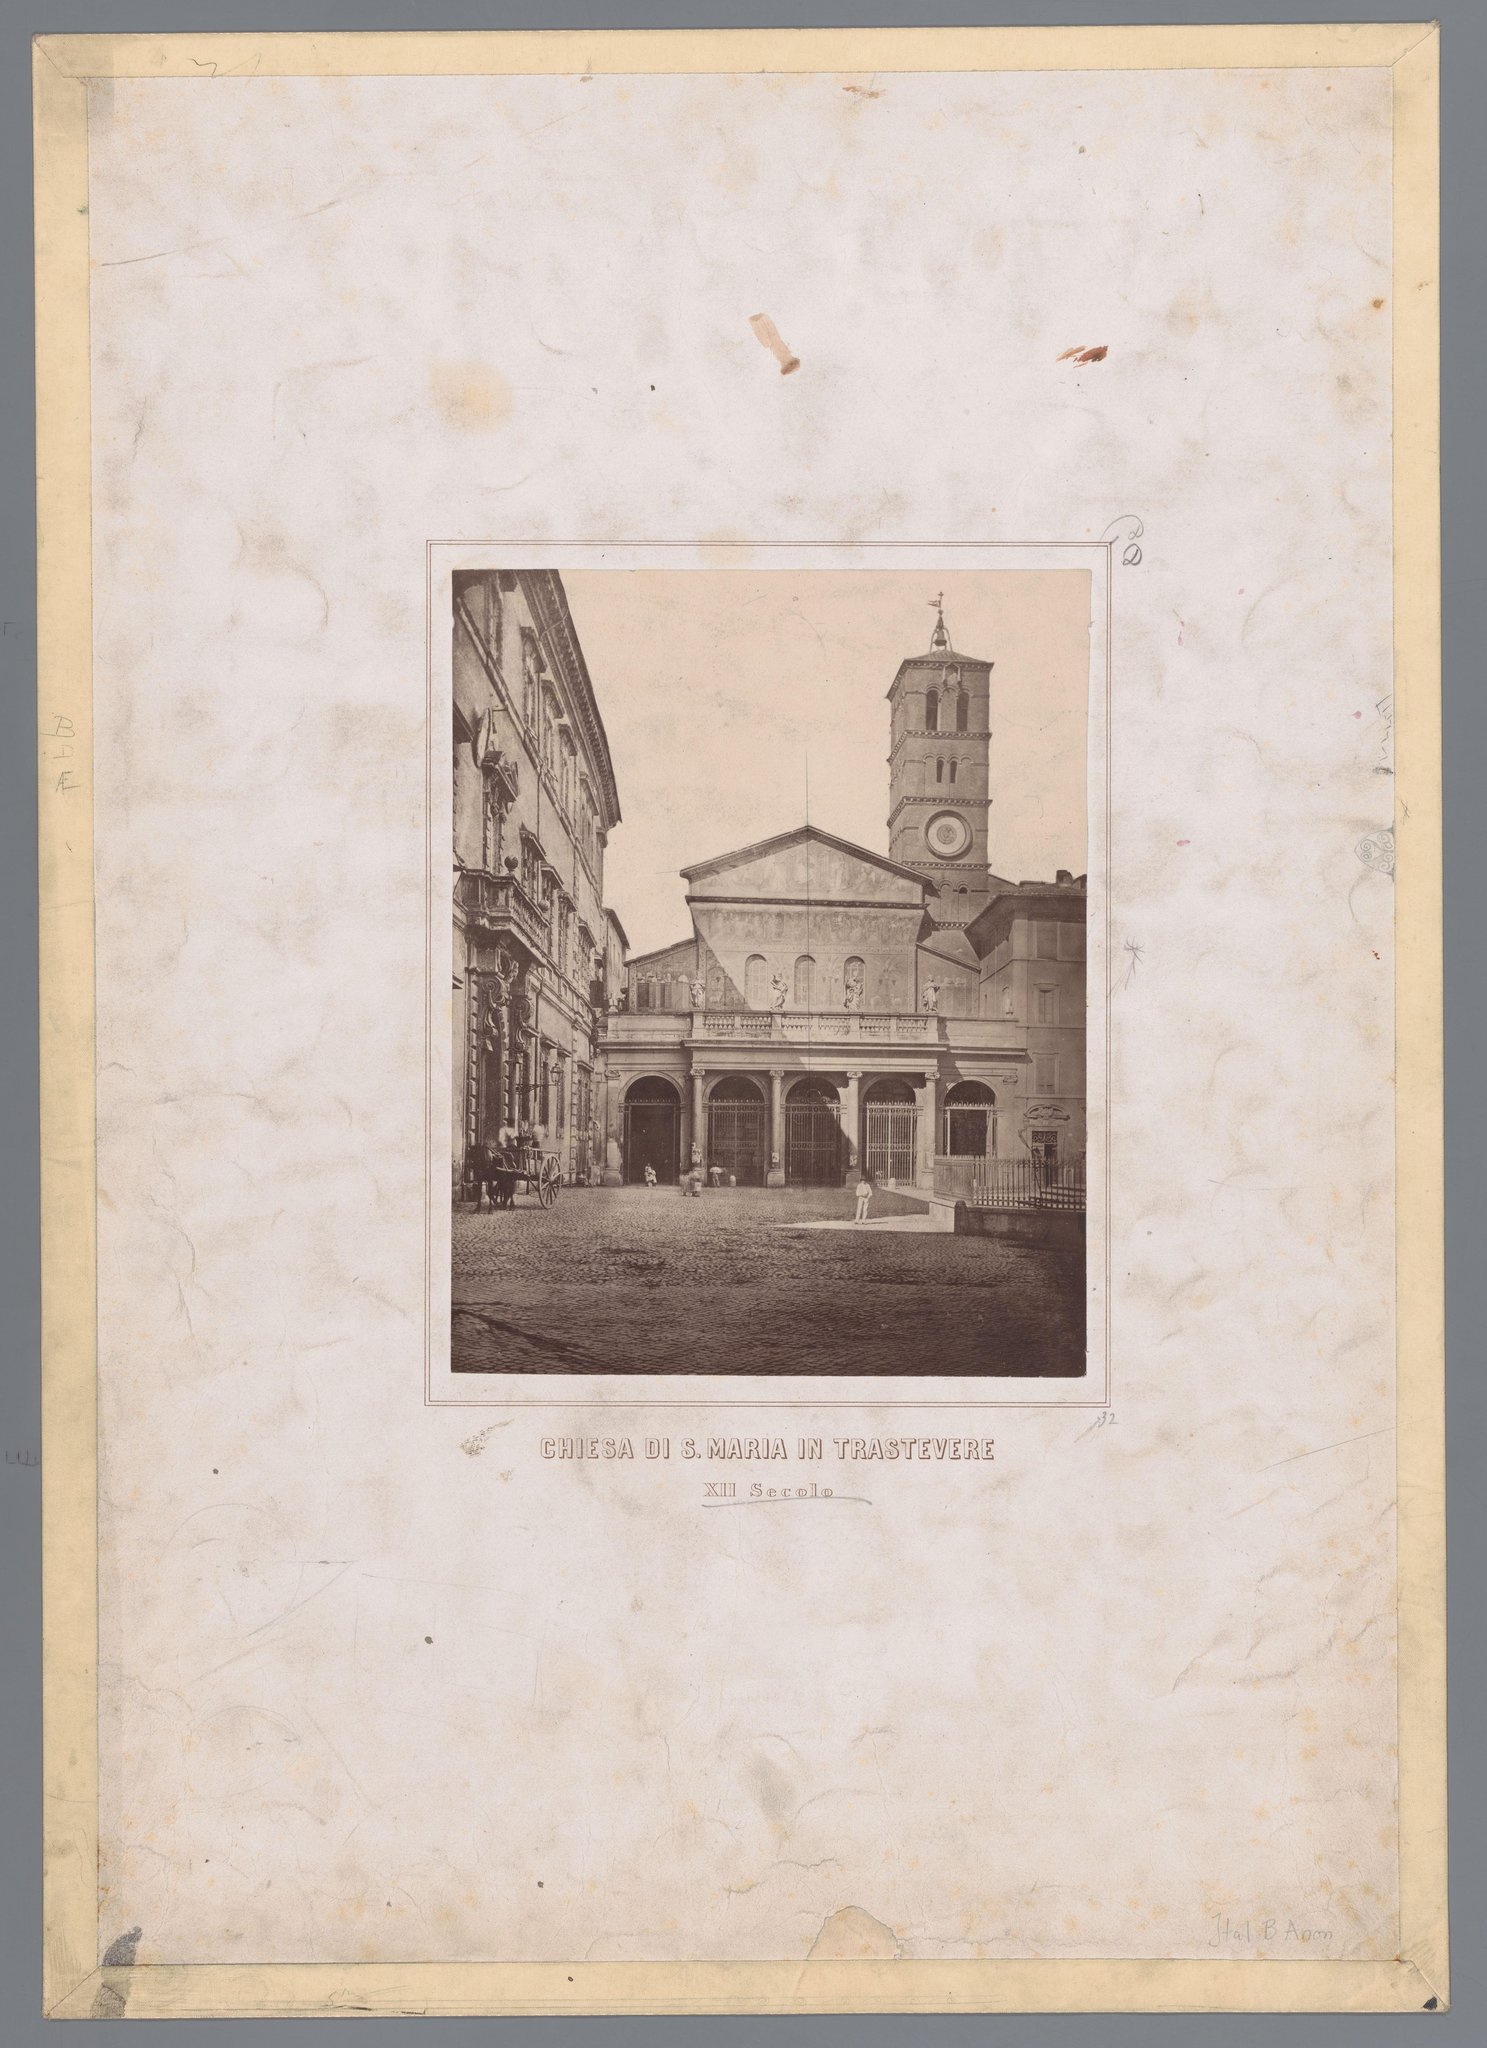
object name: photograph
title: S. Maria in Trastevere te Rome ('Chiesa di S. Maria in Trastevere. XII Secolo')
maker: Anonymous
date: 1865-1885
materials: cardboard, paper, photographic support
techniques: albumen print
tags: santa maria in trastevere